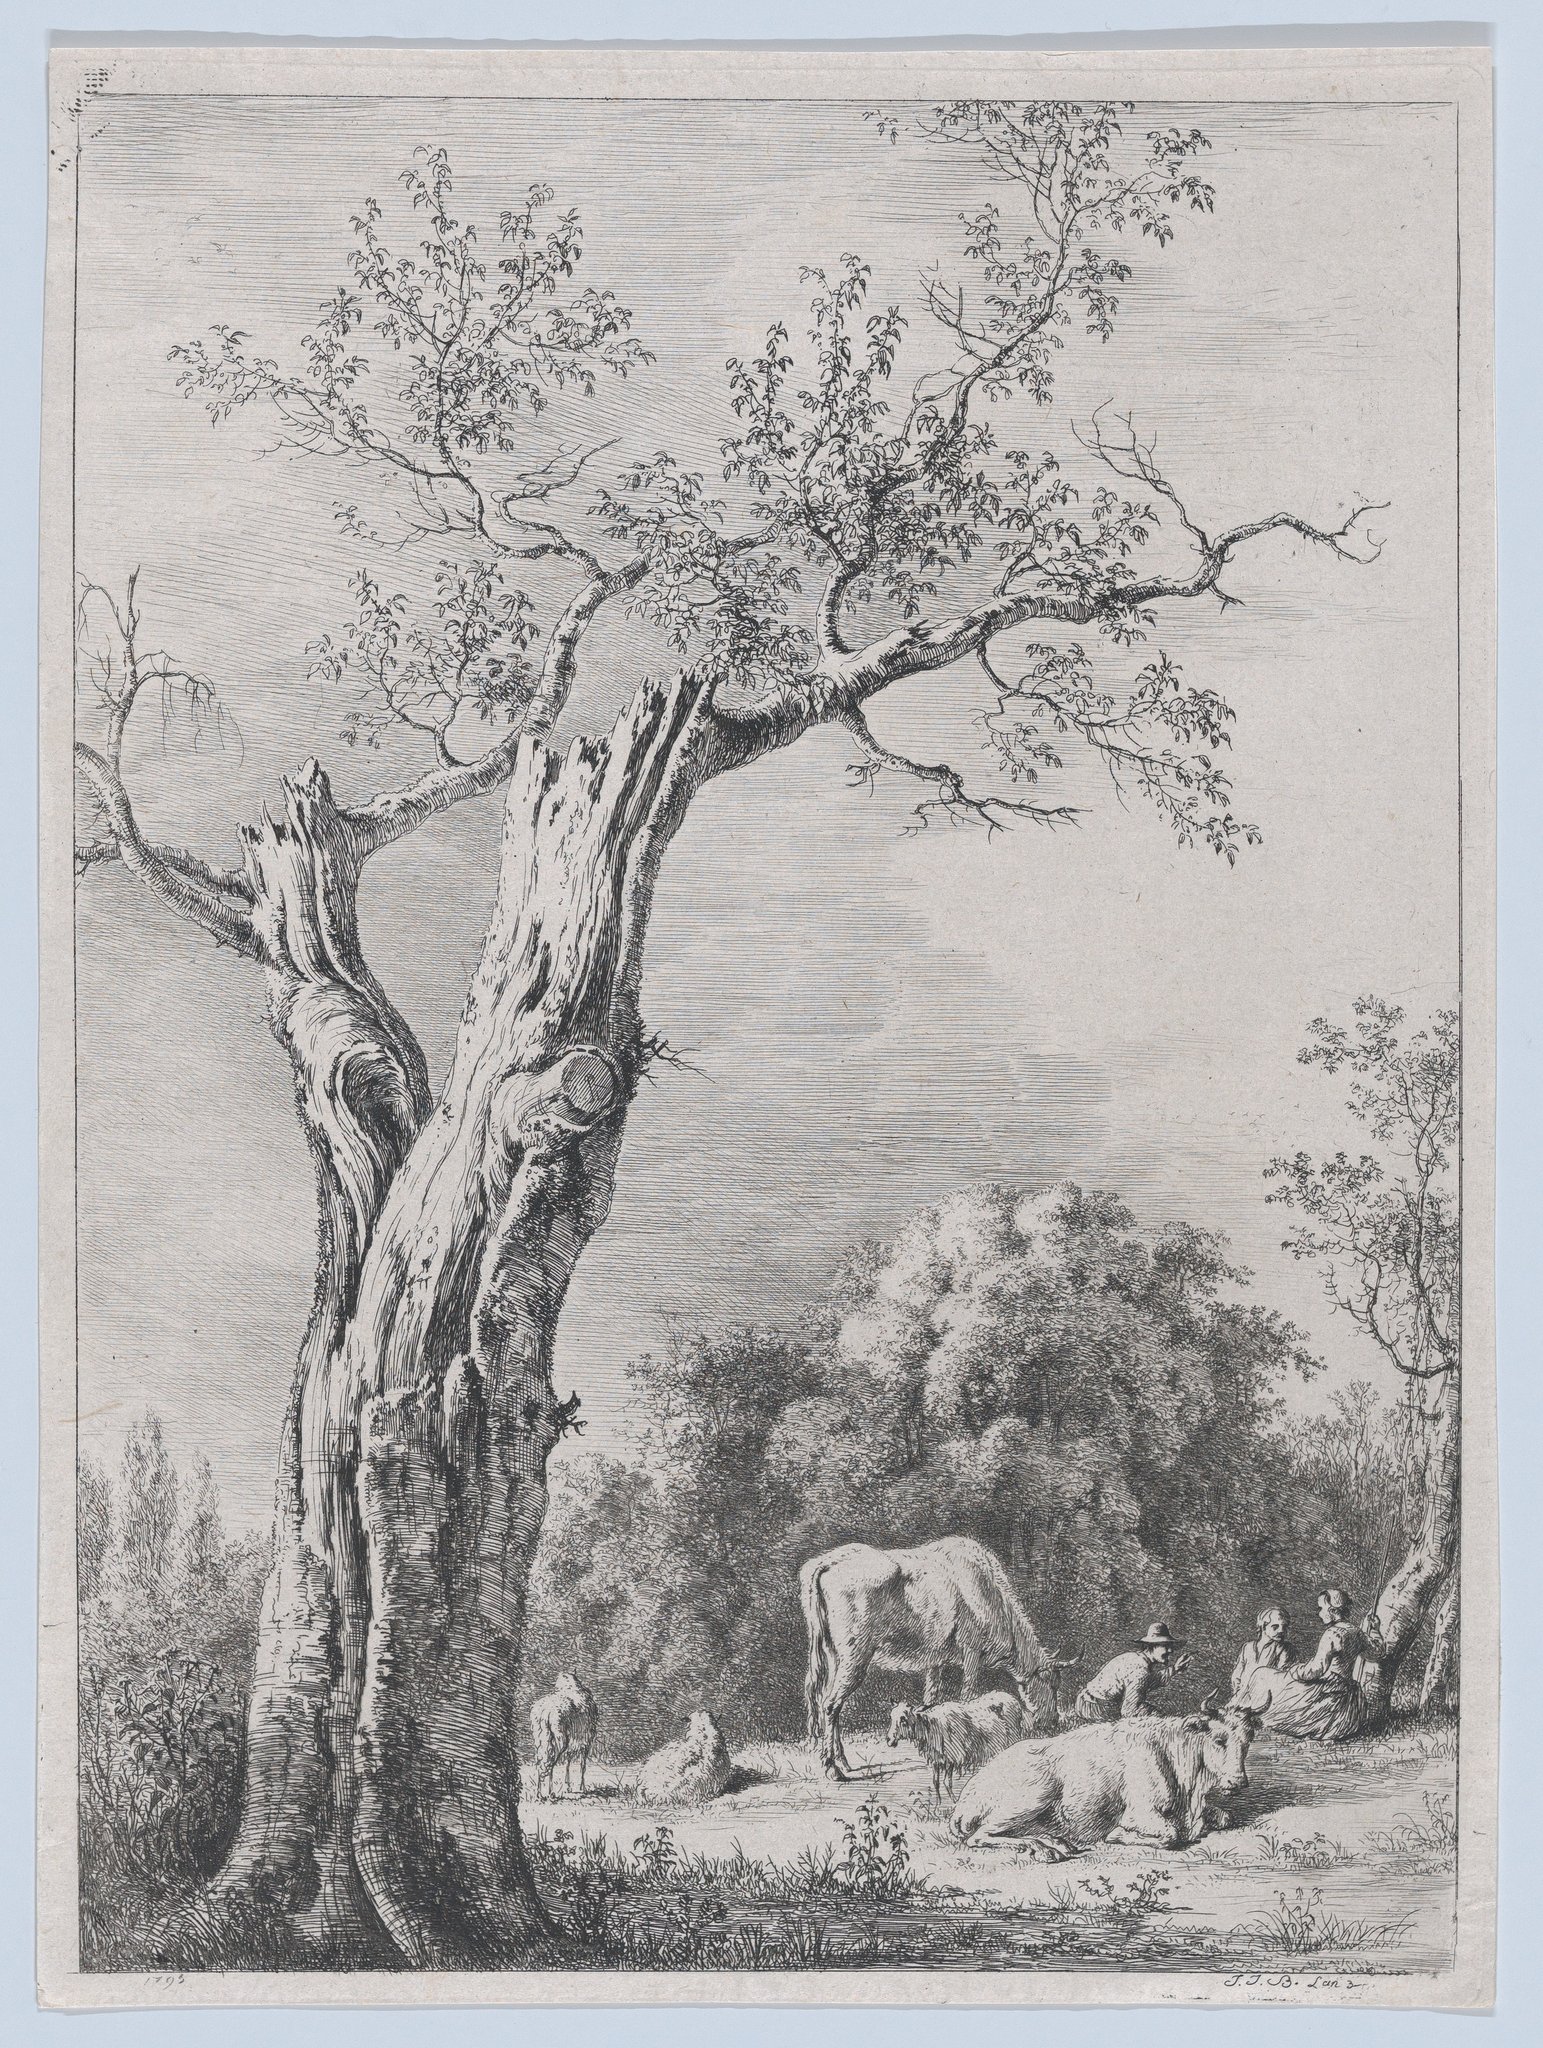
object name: print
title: Spring, after a drawing completed in Saint-Chamond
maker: jean jacques de boissieu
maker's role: artist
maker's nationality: french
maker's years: 1736-1810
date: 1795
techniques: etching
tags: women,cows,horses,trees,spring